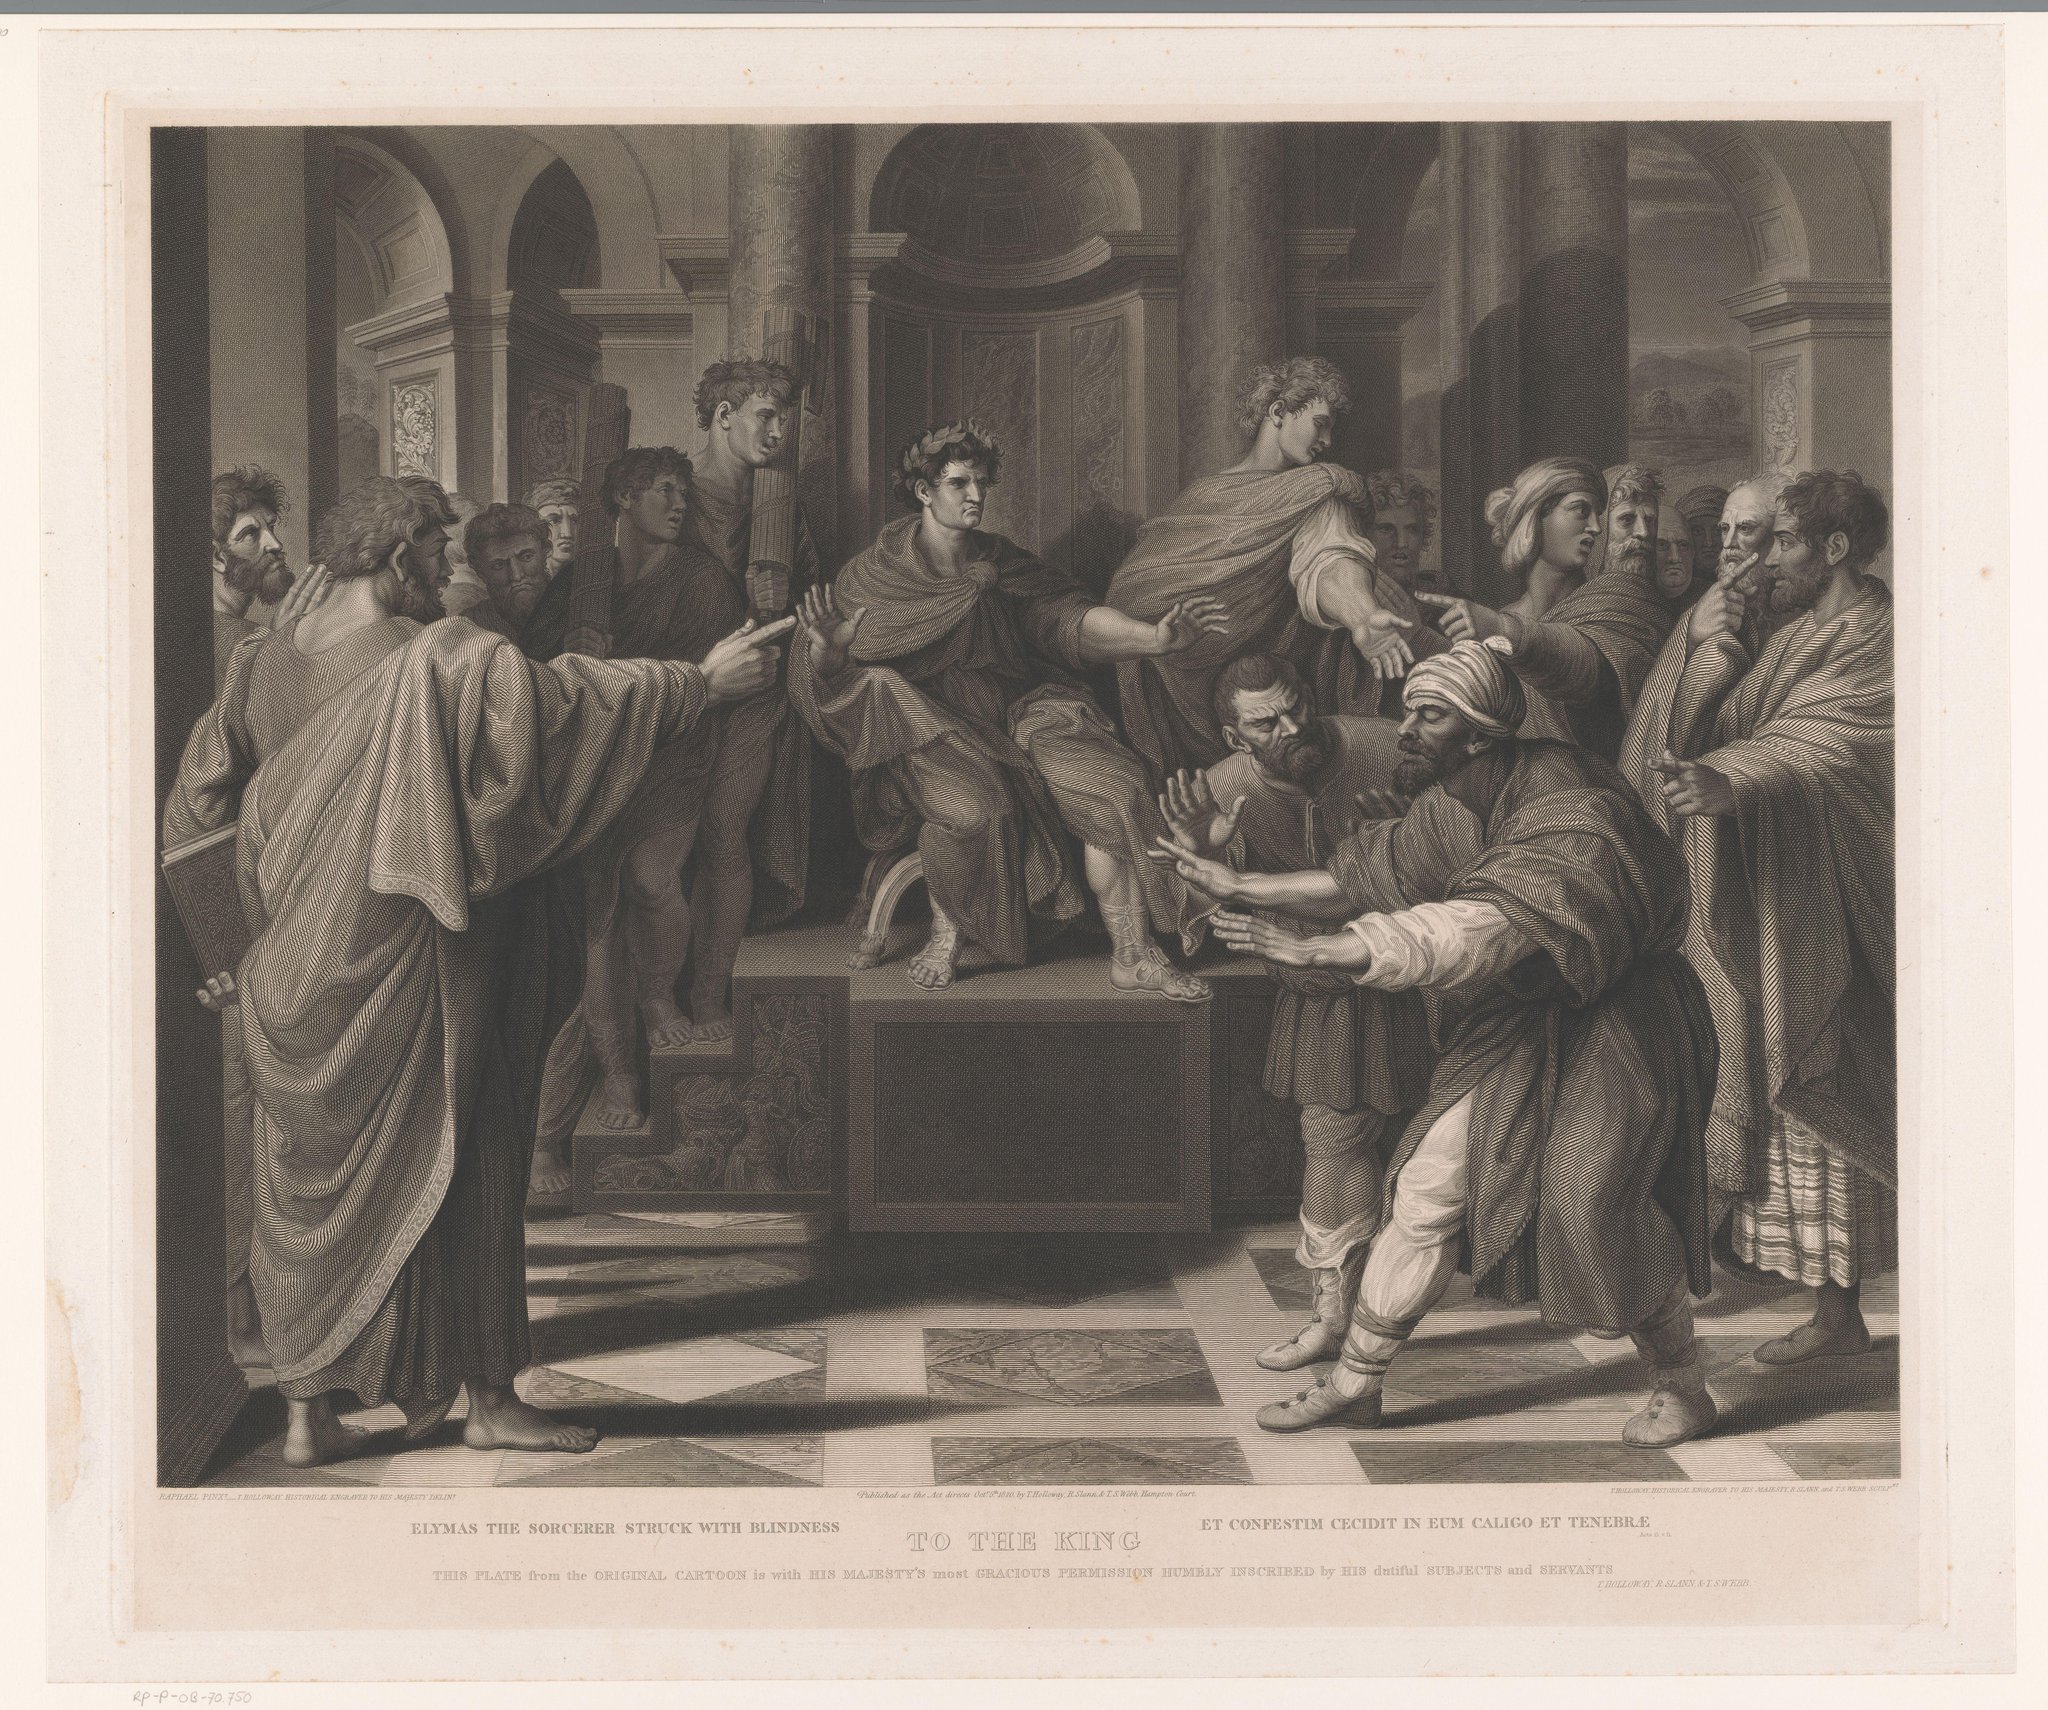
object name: print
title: The Raphael Cartoons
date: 1810-1820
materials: paper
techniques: engraving, etching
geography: london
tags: the sorcerer elymas (elymes, bar-jesus), who tries to prevent paul and barnabas from speaking, is struck blind by paul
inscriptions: collector's mark: Lugt 12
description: Serie van zes prenten, deels in samenwerking met Robert Slann en T.S. Webb. De laatste prent van de serie werd in 1828 uitgegeven.